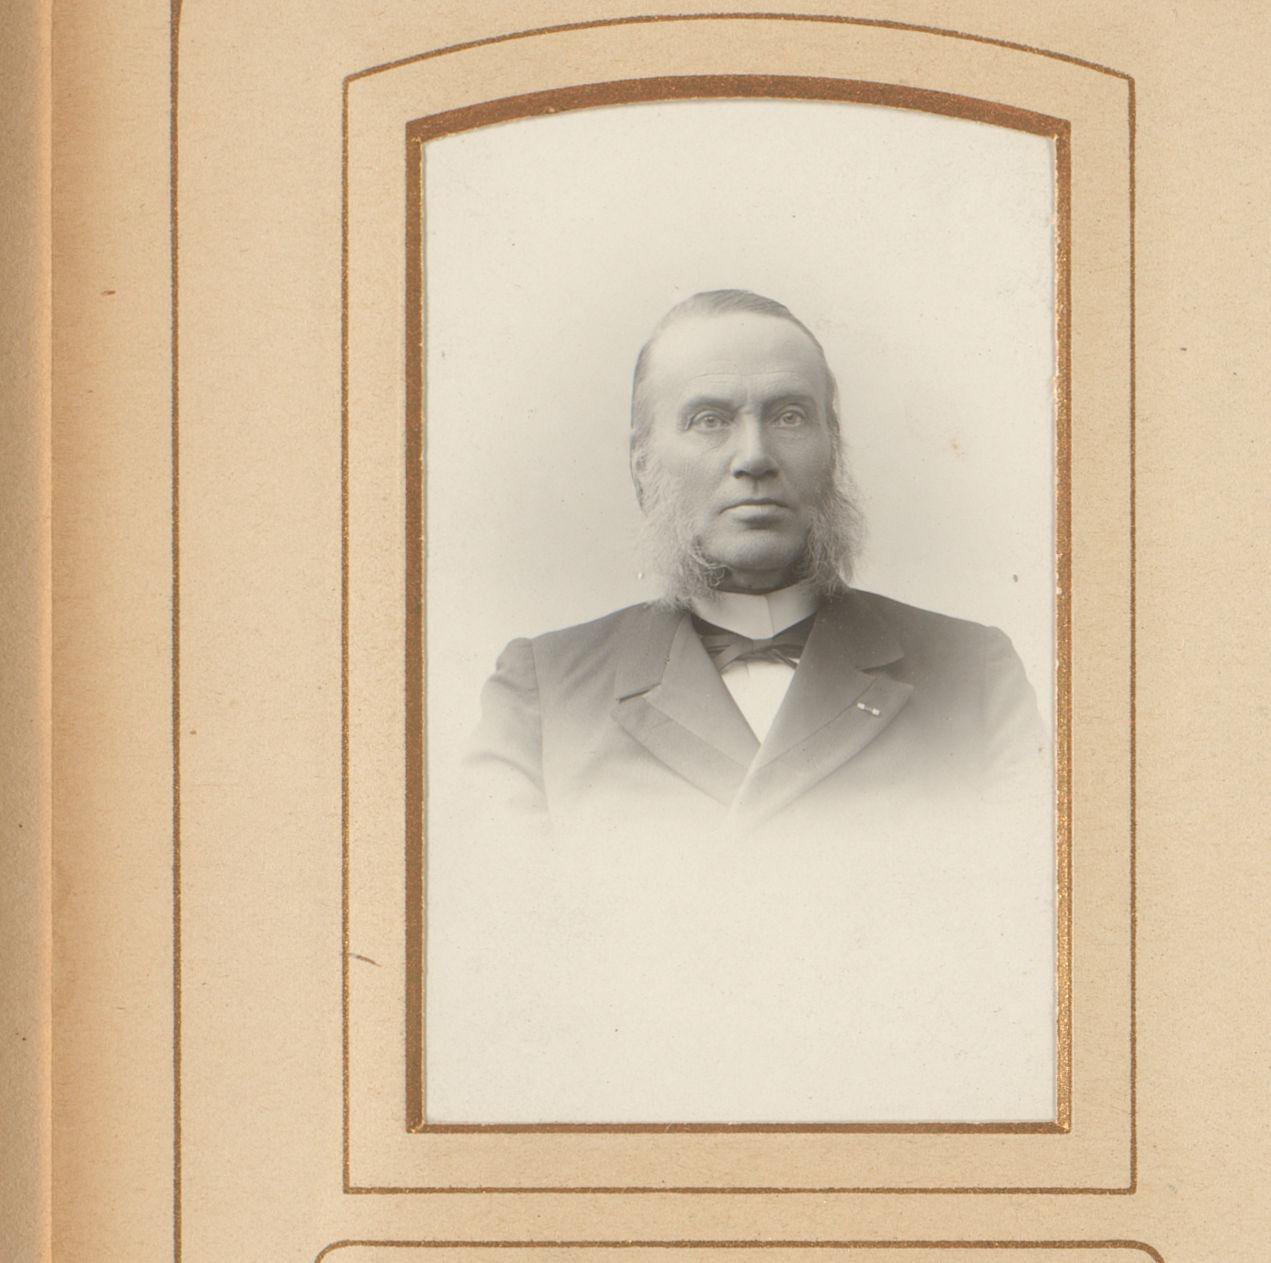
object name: album leaf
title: Portret van een man met bakkebaarden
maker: Anonymous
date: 1890-1920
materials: cardboard, photographic support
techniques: collodion silver print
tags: sideburns, historical persons